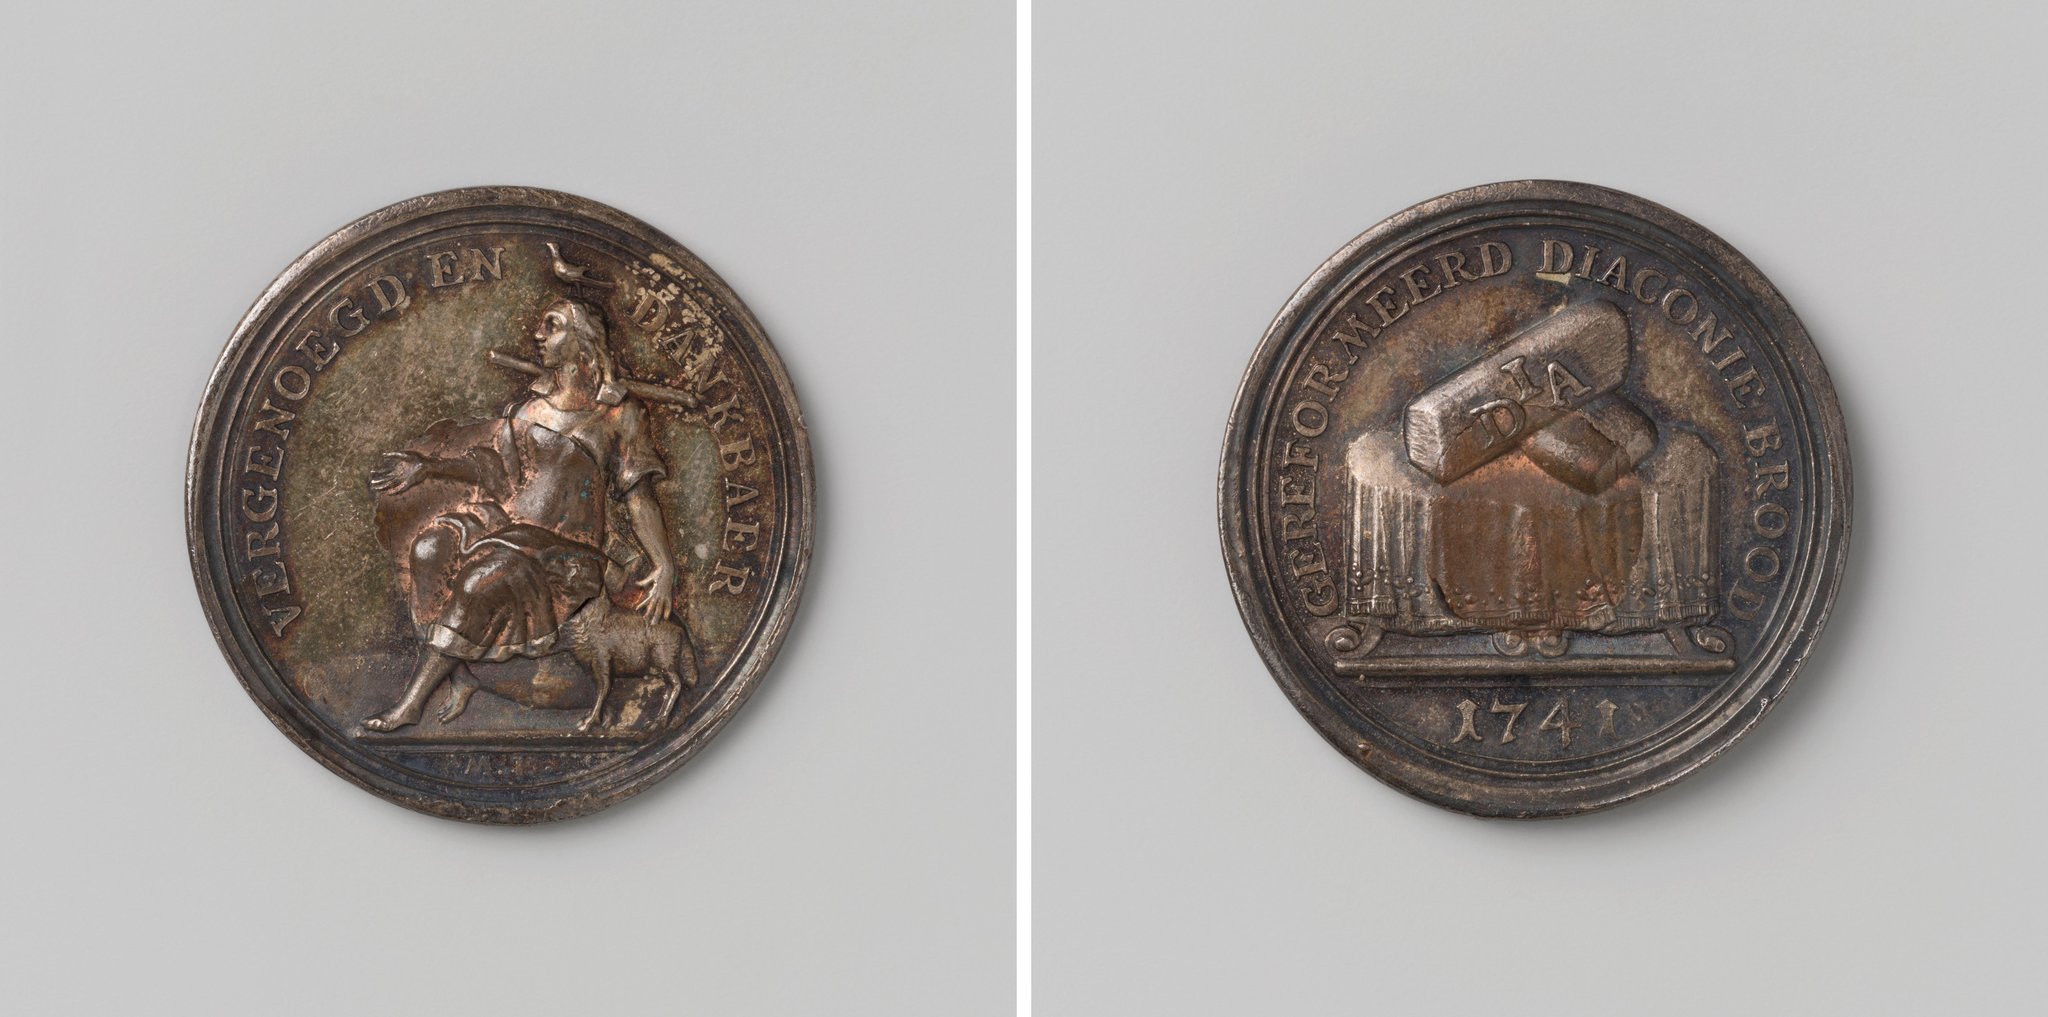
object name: broodpenning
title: Gereformeerde Diakonie te Amsterdam, penning in de vorm van een armenpenning die behoeftige kerklidmaten bij uitdeling recht gaf op brood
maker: martinus holtzhey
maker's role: medailleur, muntmaker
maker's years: 1697-1764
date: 1741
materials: copper, silver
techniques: striking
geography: amsterdam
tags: amsterdam